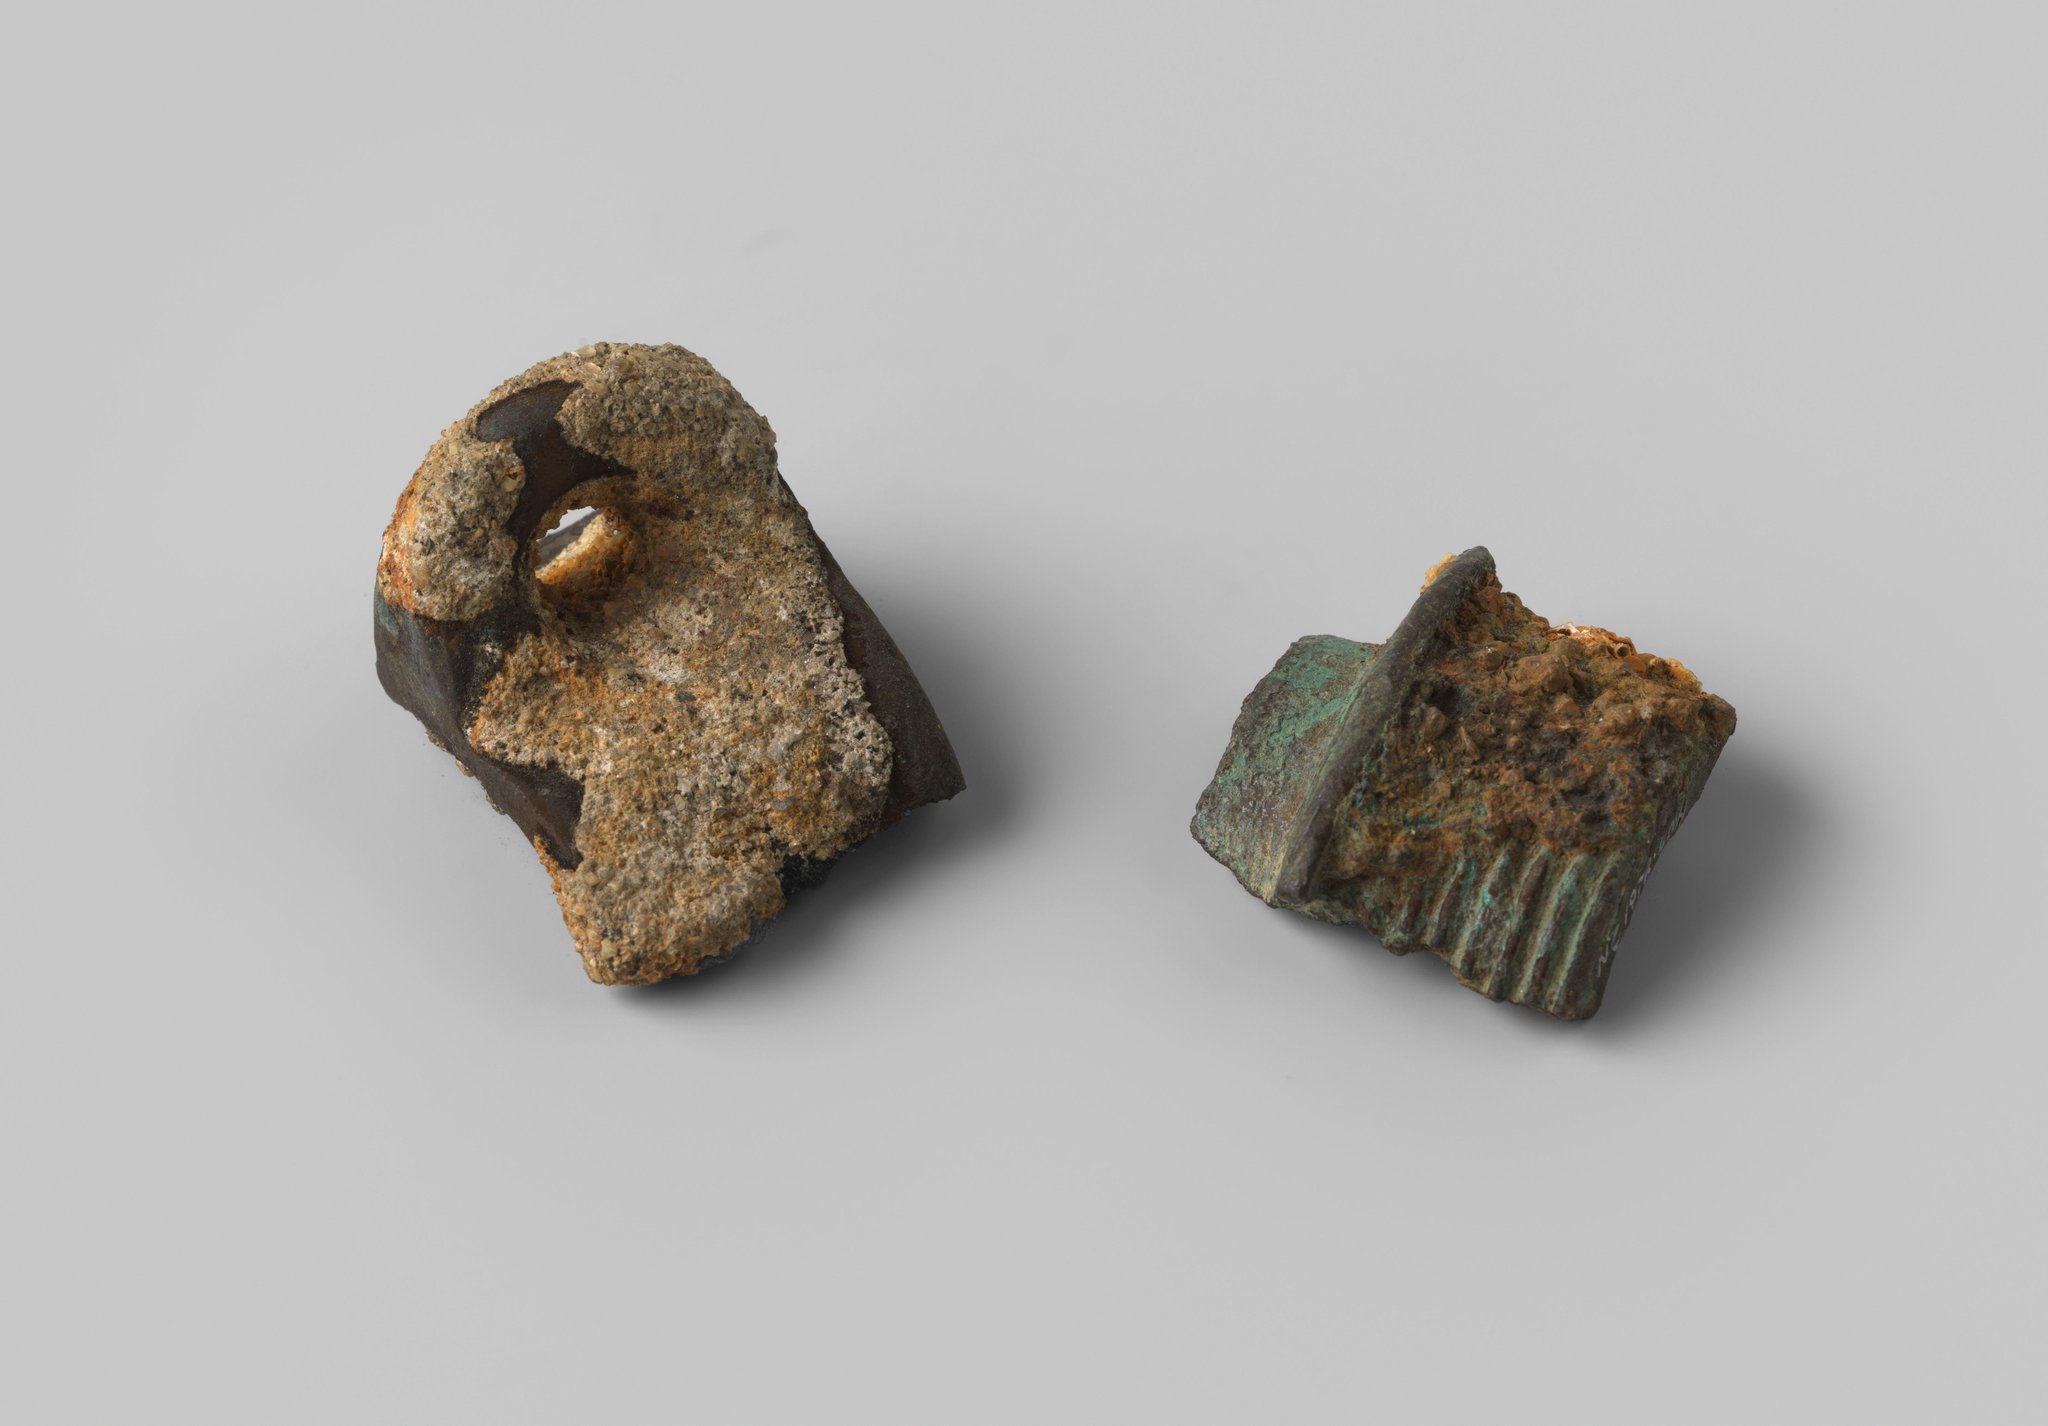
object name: firehose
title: Twee fragmenten van een koppelstuk van een brandslang uit het wrak van de Oost-Indiëvaarder Hollandia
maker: Anonymous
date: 1700-1743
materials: copper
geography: netherlands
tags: verenigde oostindische compagnie, hollandia (schip), annet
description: Fire engine, firehose coupling; fragment of internally threaded ring with semicircular pierced loop, id. NG-1978-29-H-649.